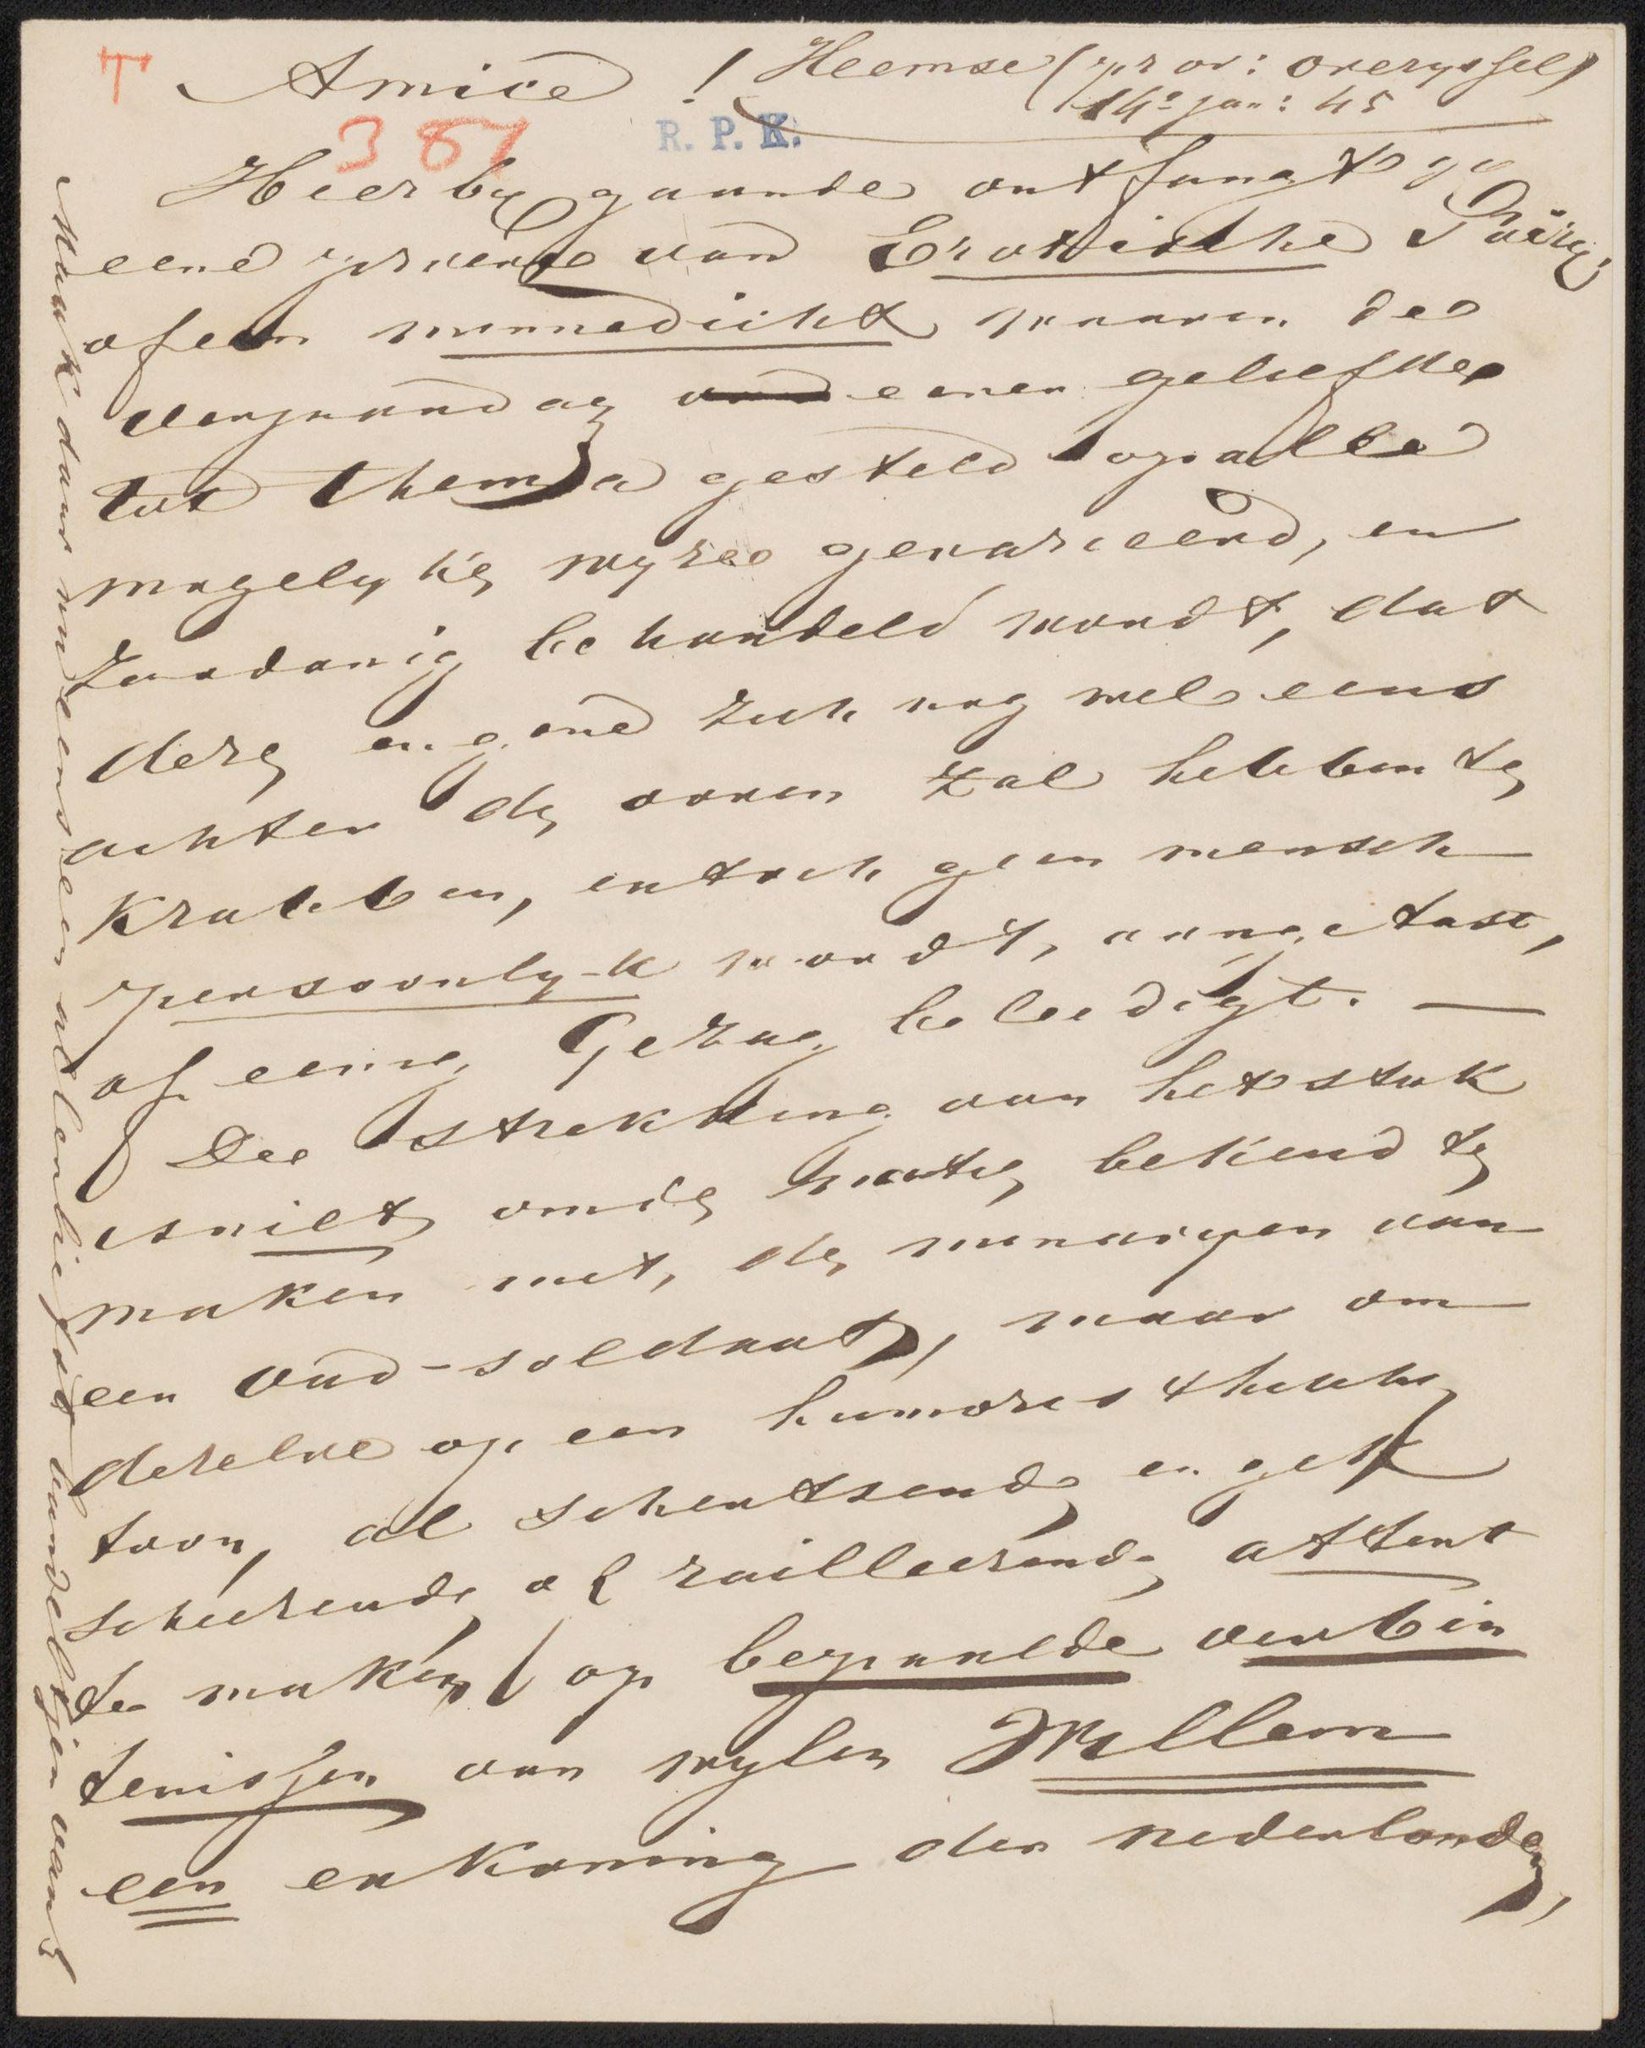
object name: letter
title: Brief aan anoniem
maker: george anne christiaan willem markies de thouars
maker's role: dichter, luitenant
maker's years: 1807-1850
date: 1845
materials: ink, paper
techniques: pen, writing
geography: heemse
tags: literature ~ arts, money, printed matter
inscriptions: collector's mark: Lugt 2233